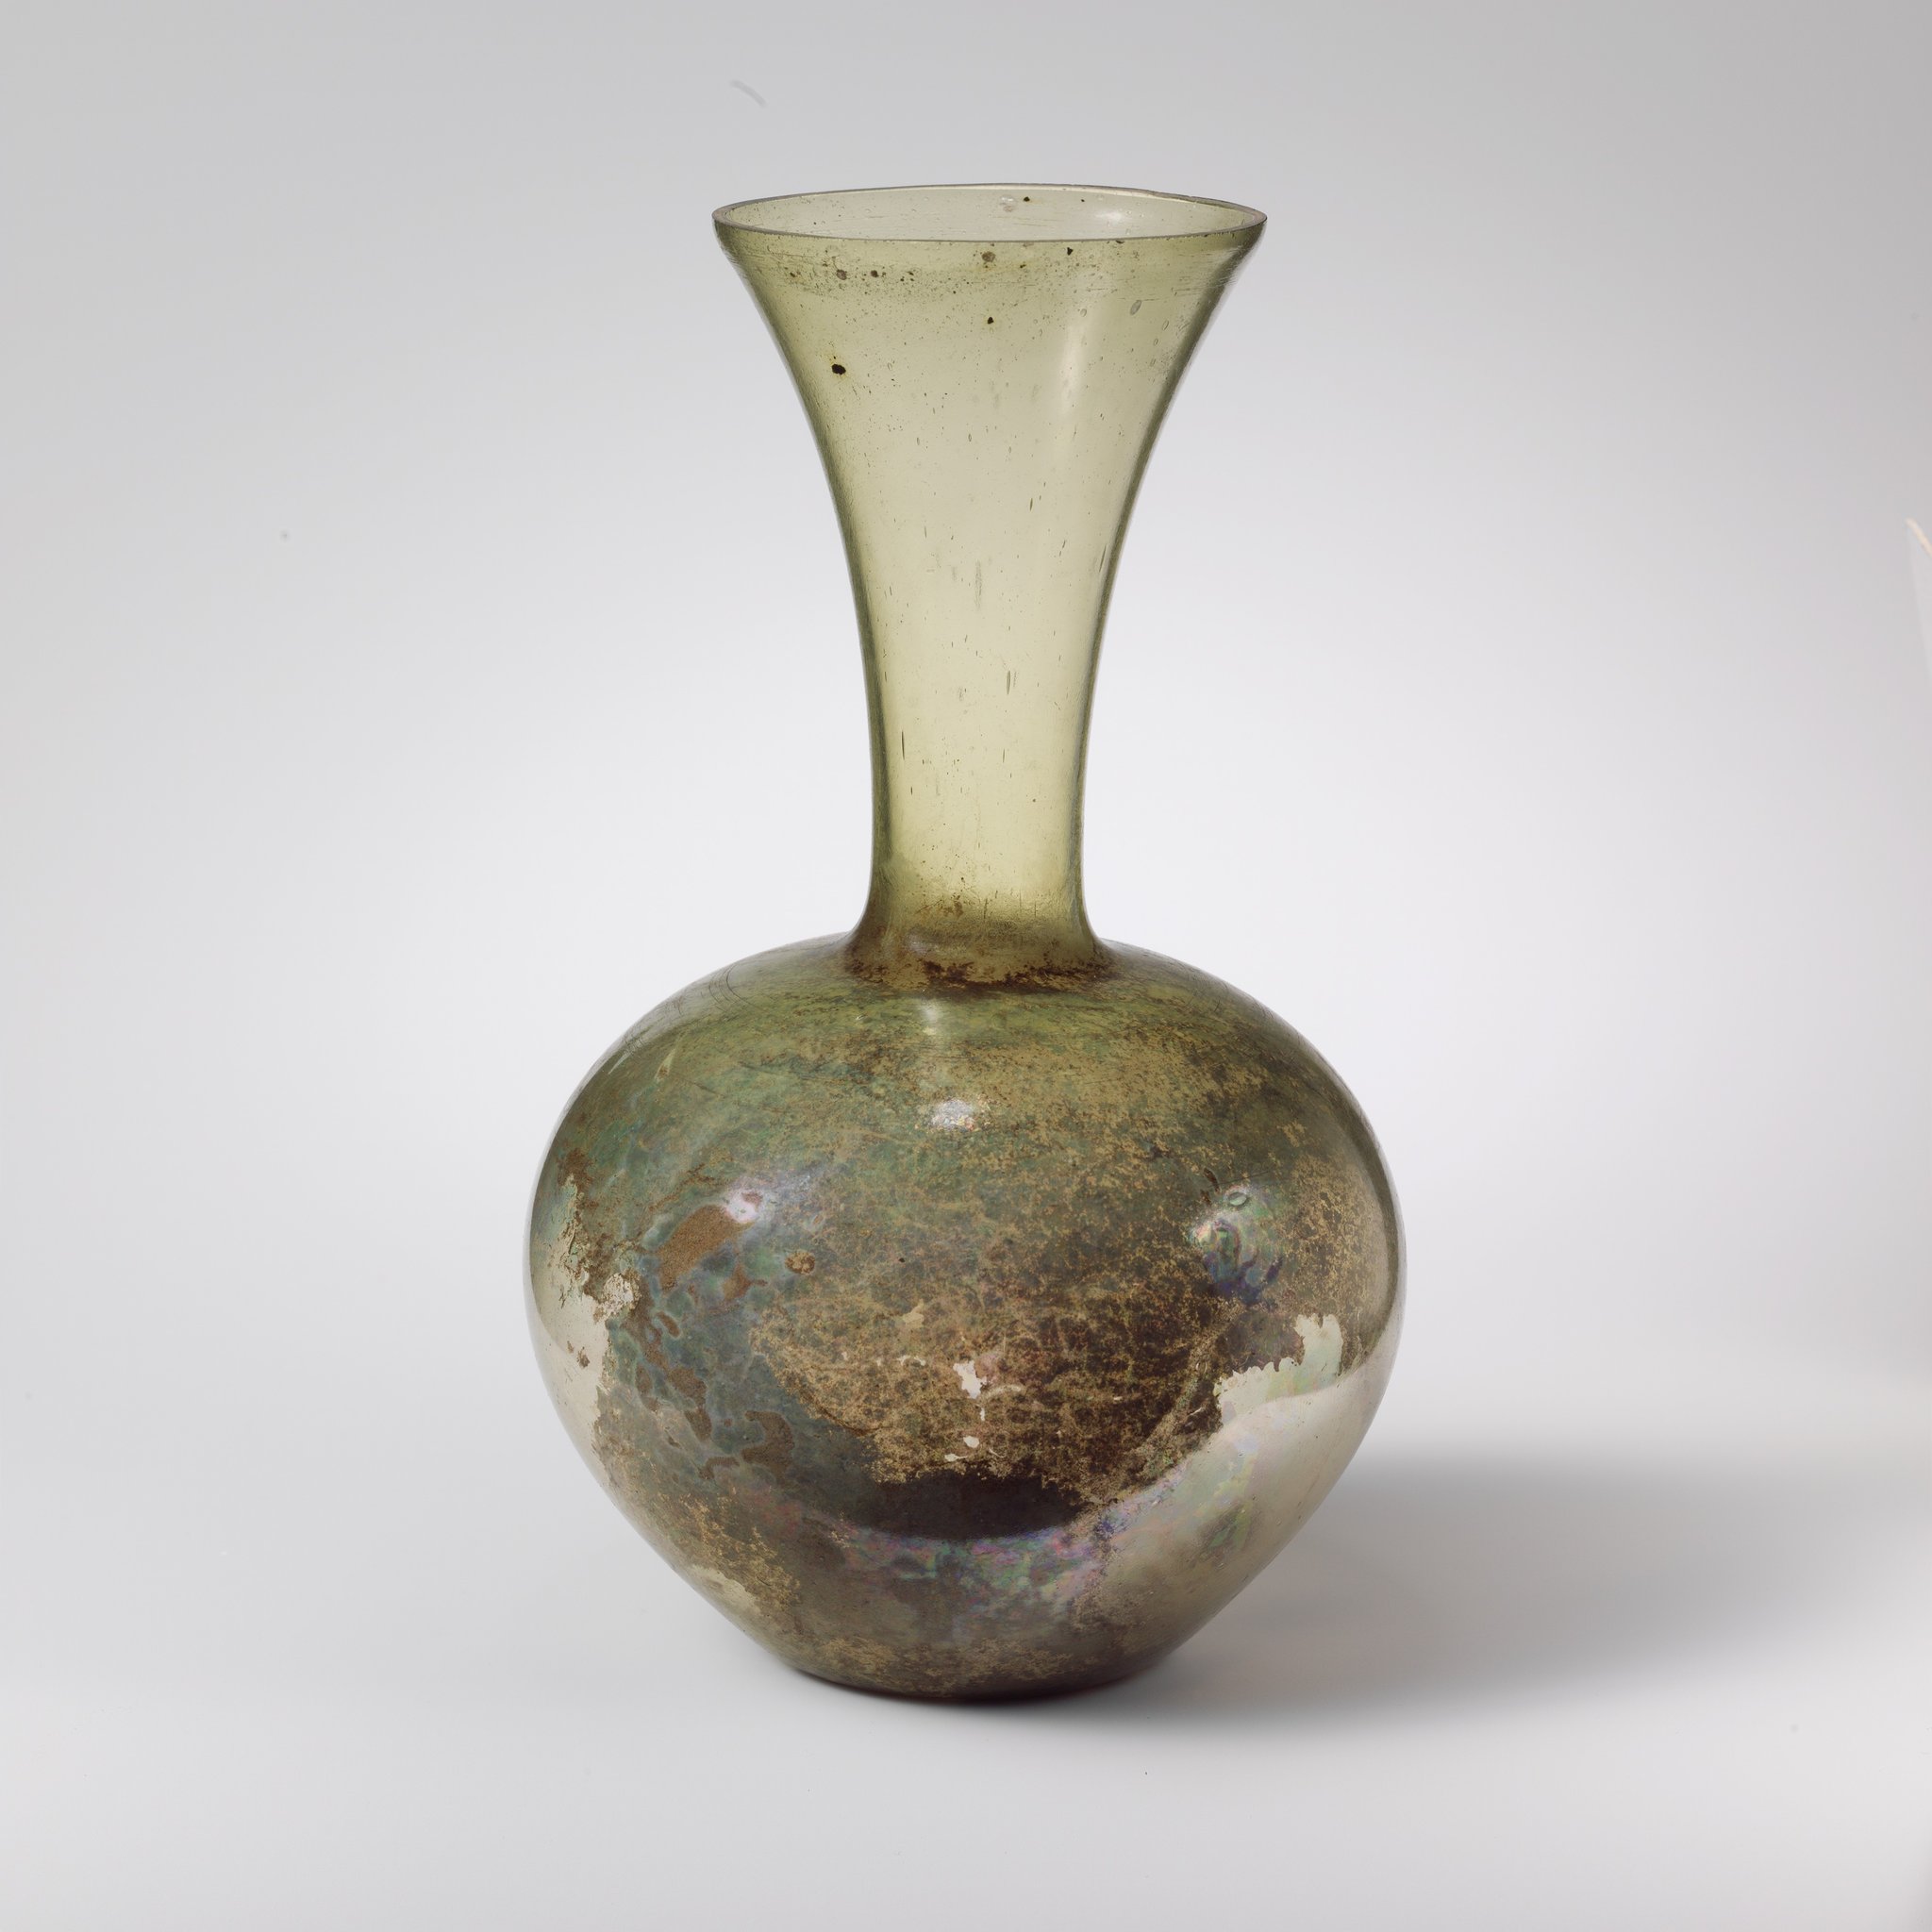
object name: bottle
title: Glass bottle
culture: roman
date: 301-400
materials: glass